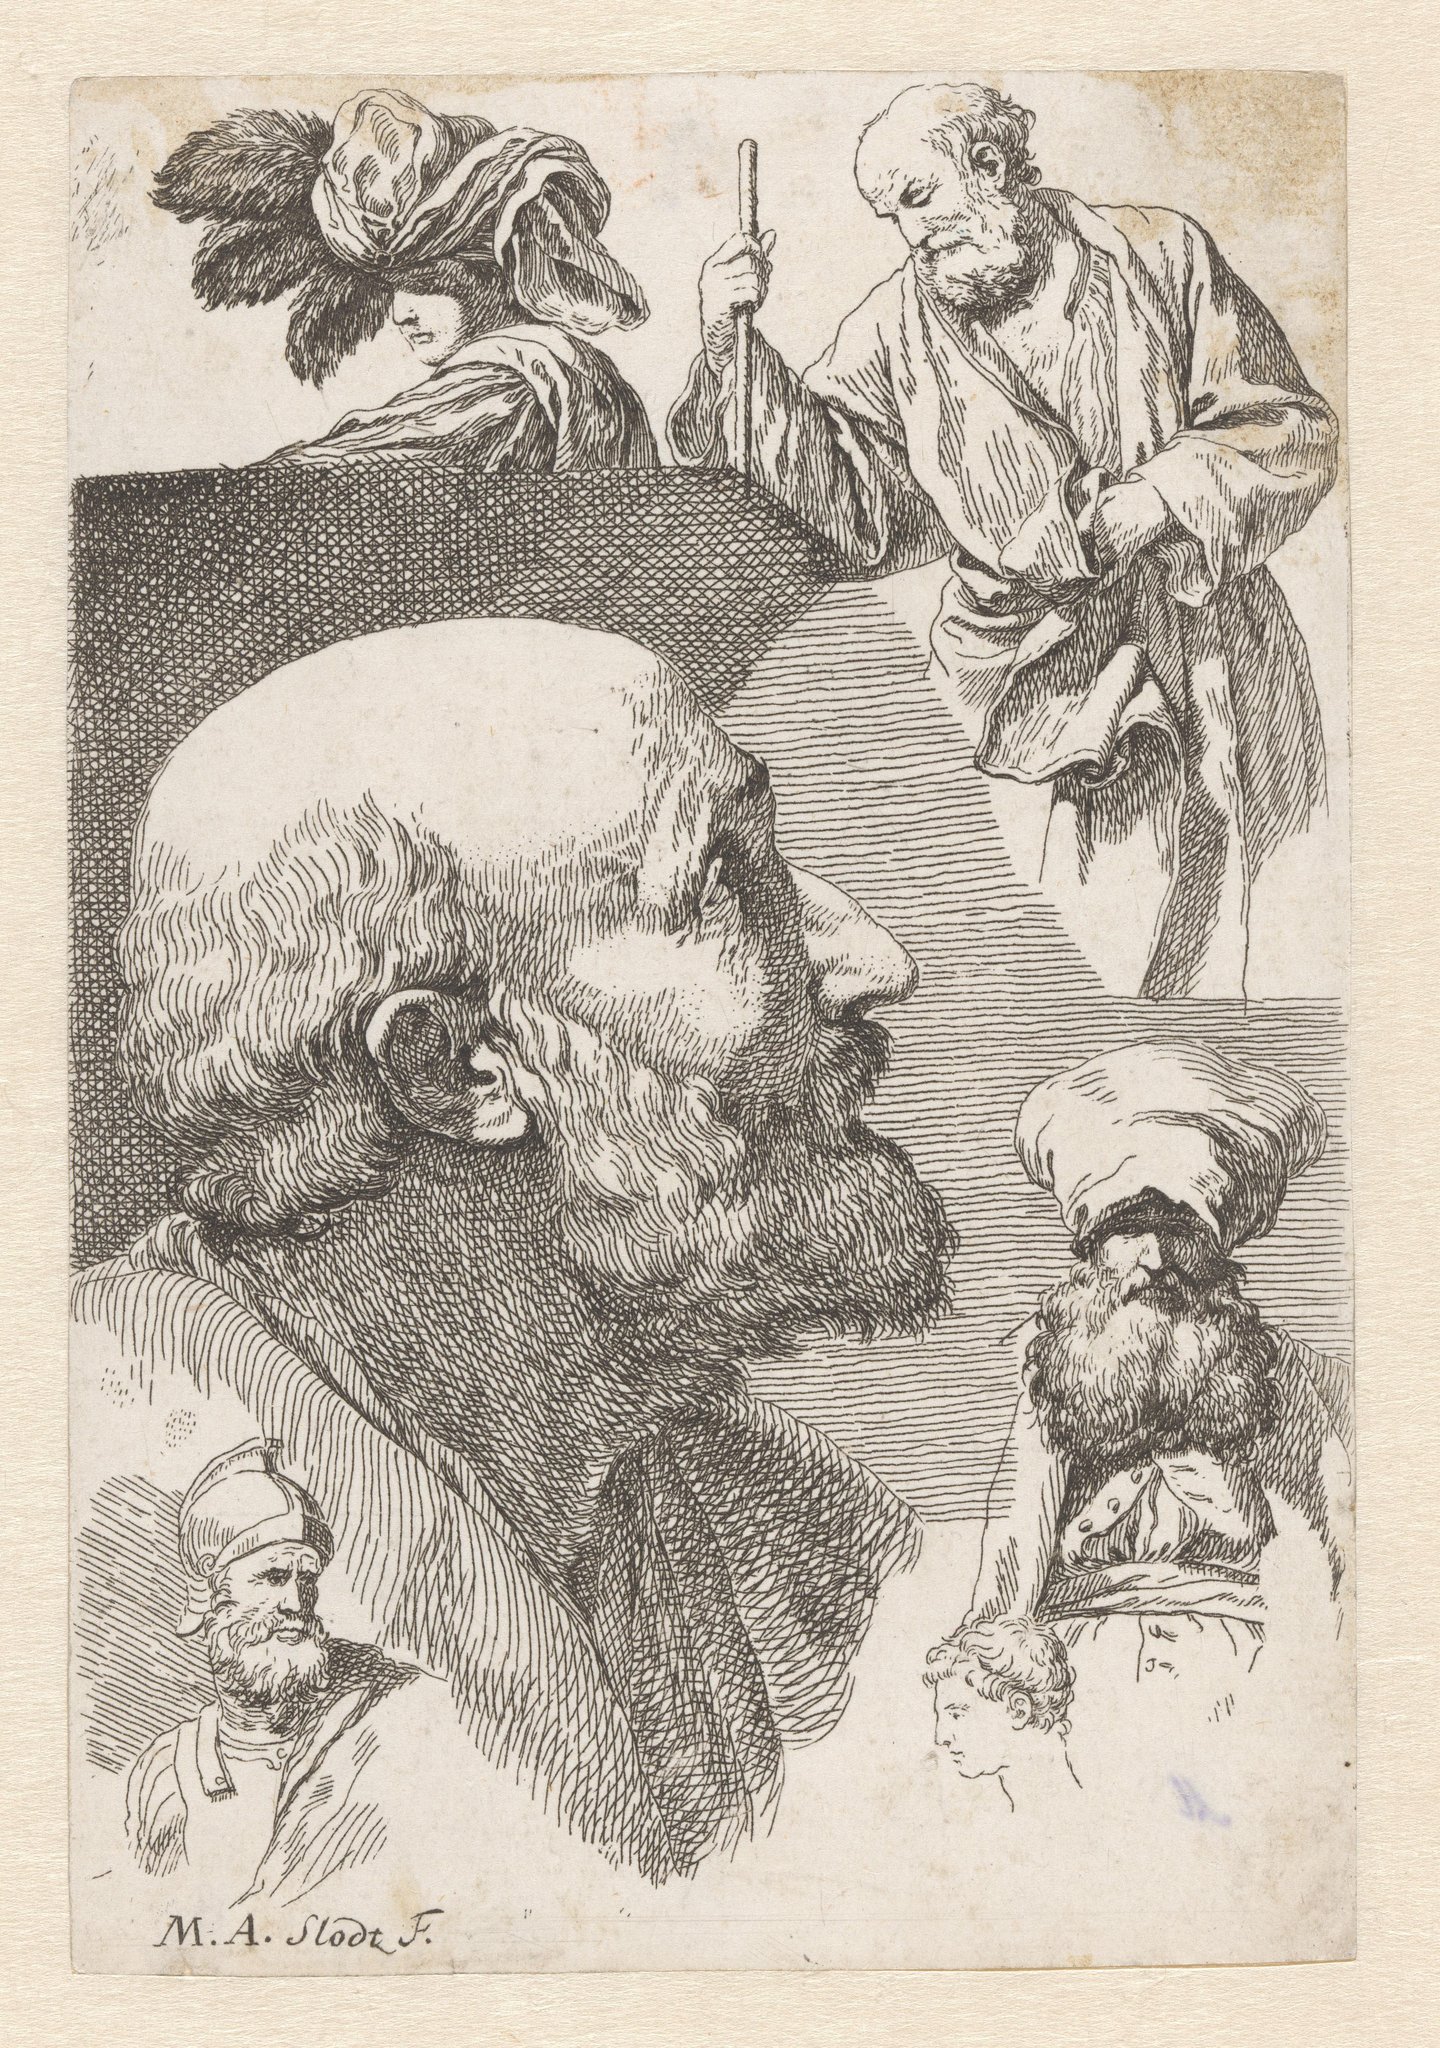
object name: print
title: Studies van verschillende figuren en hoofden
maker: rené michel slodtz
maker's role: draughtsman, sculptor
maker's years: 1705-1764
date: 1725-1730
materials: paper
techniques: etching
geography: paris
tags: postures of the head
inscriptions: collector's mark: Lugt 2228, stamp:, collector's mark: Lugt 2760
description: Studies van verschillende hoofden en figuren, waarschijnlijk gekopieerd naar prenten van onder meer Castiglione.